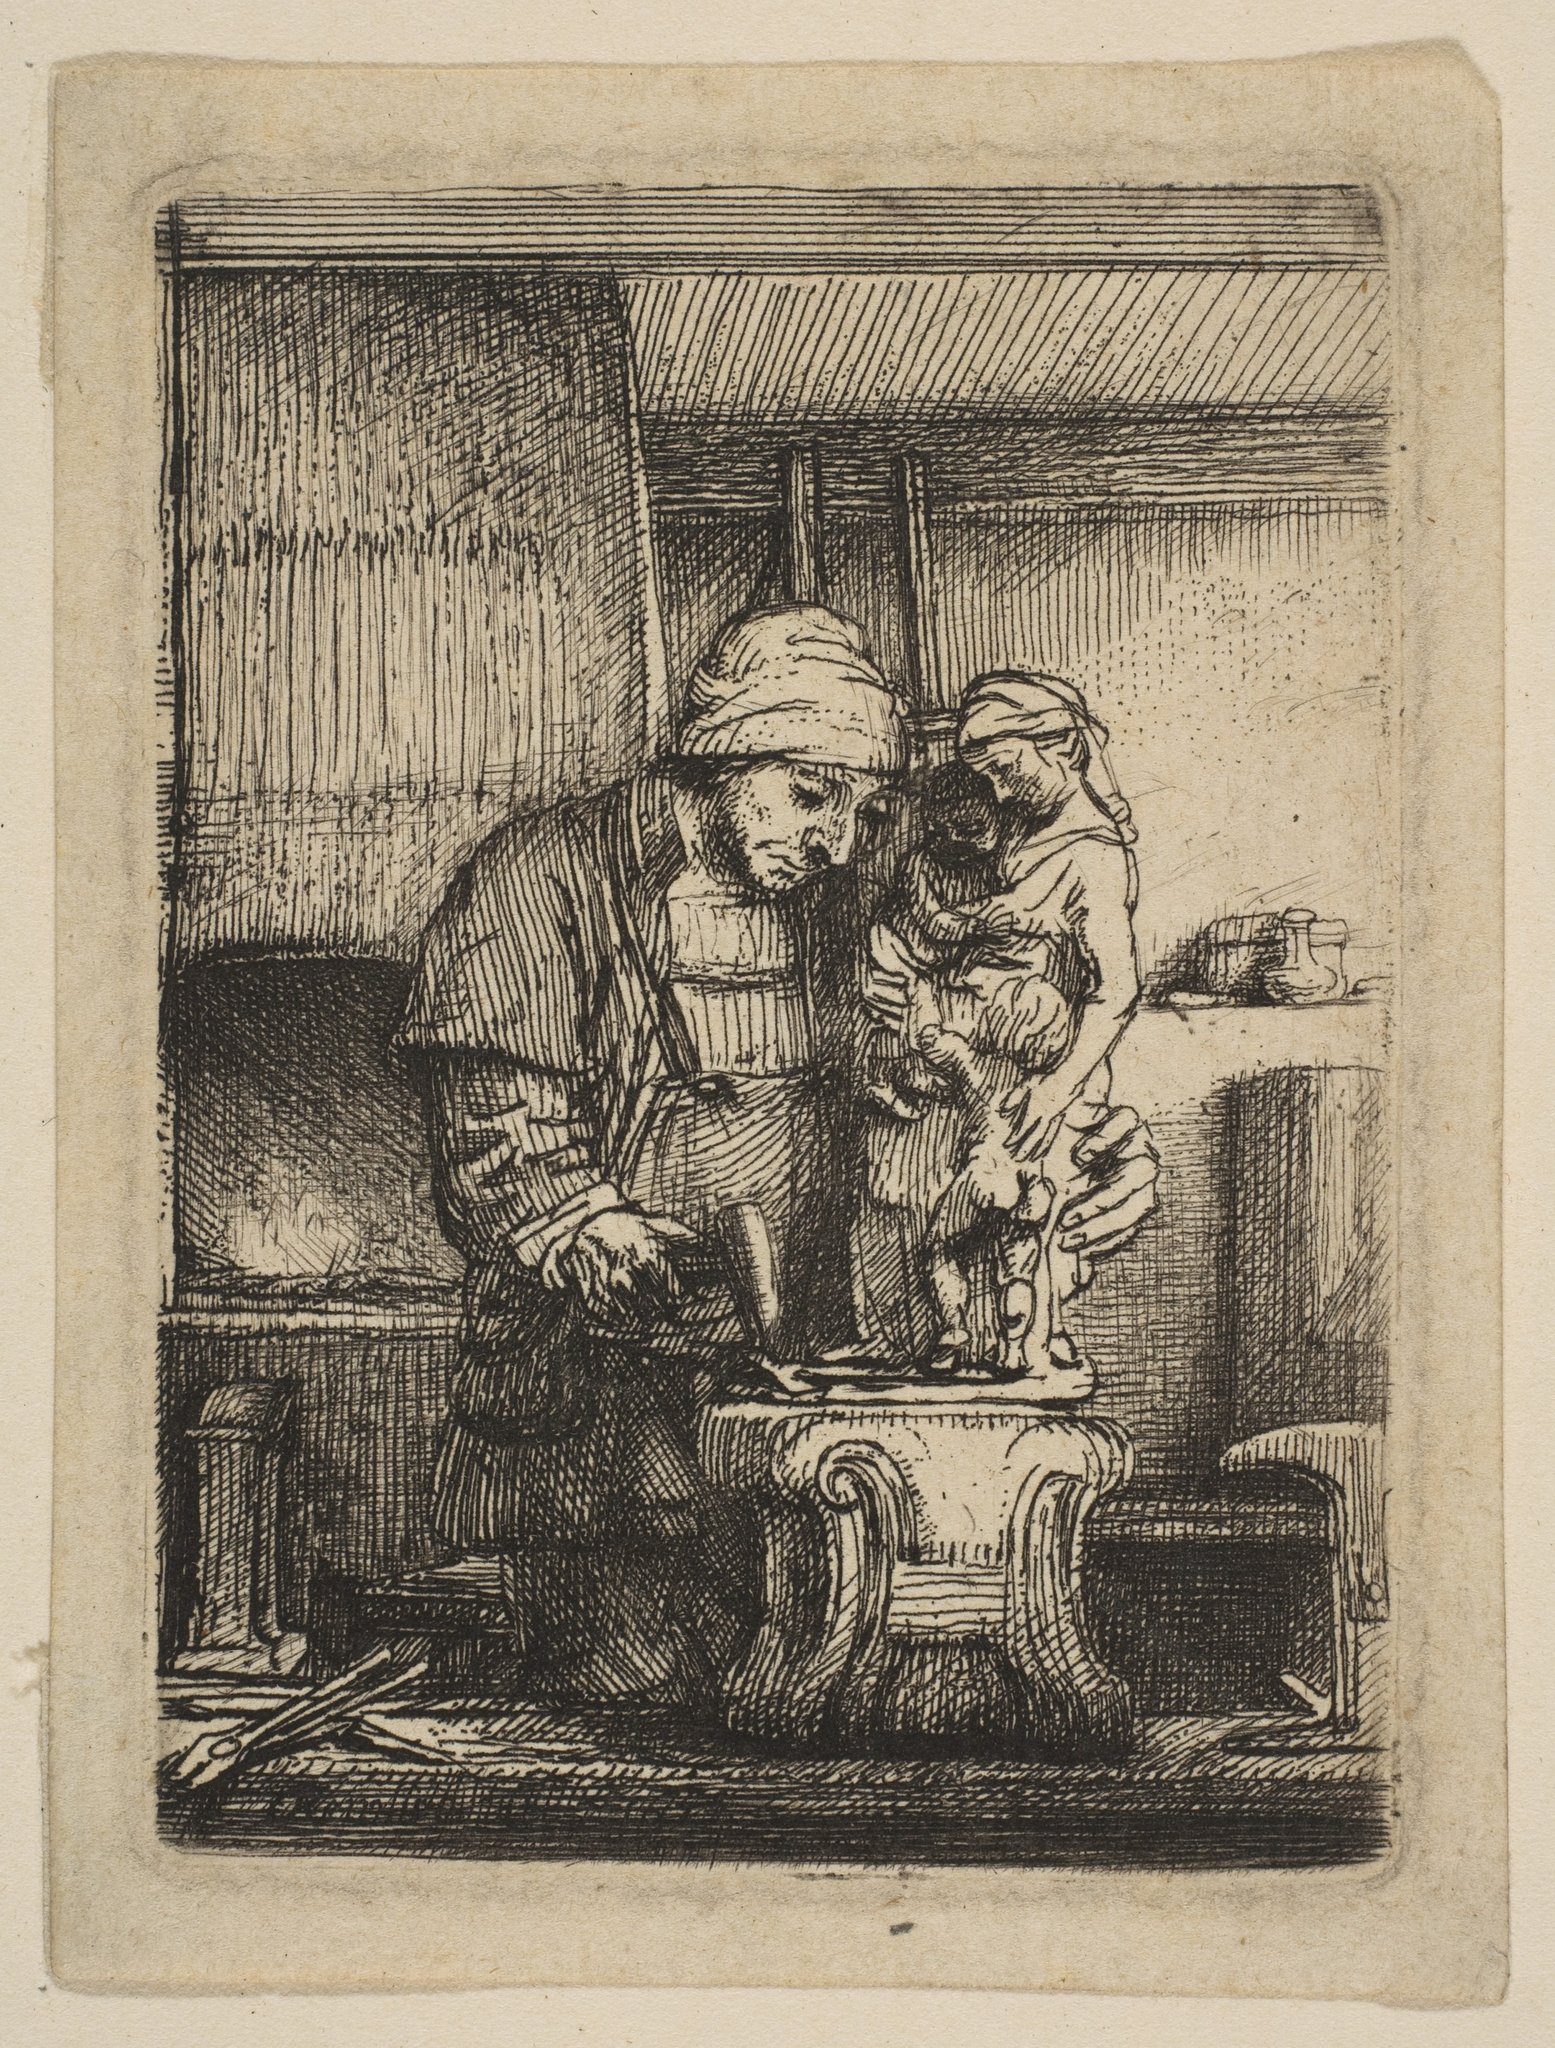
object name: print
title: The Goldsmith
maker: rembrandt van rijn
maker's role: artist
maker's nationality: dutch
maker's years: 1606-1669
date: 1655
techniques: drypoint, etching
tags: sculpture,men